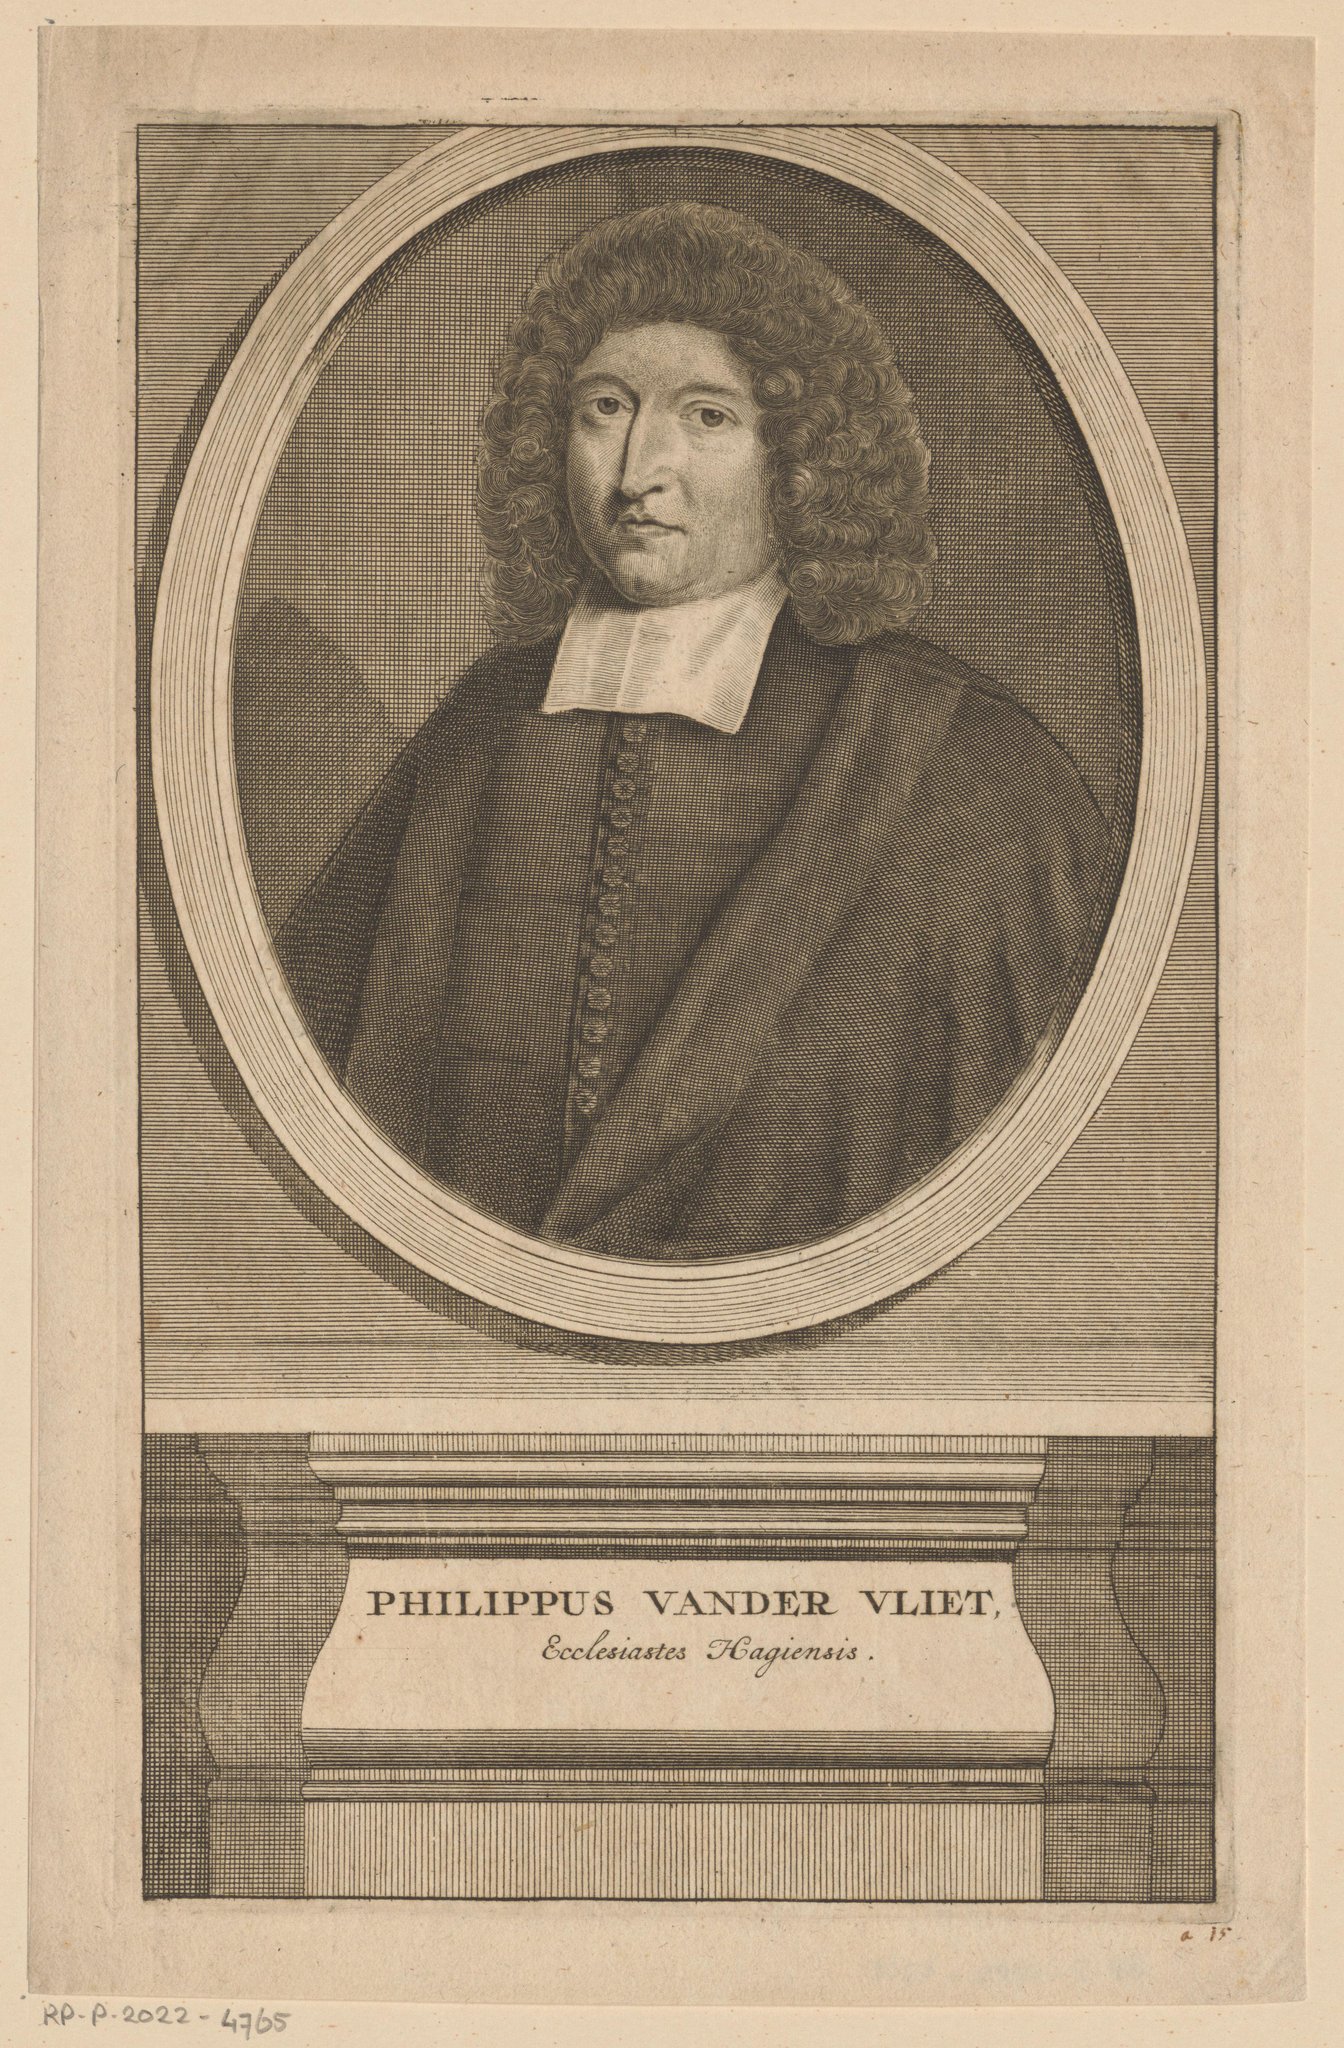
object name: print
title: Negentien portretten van theologen en filologen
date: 1687-1695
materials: paper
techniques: engraving, etching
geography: northern netherlands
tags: theologian, historical persons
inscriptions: number: ‘a15’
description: Rechtsonder handgeschreven genummerd: a15.